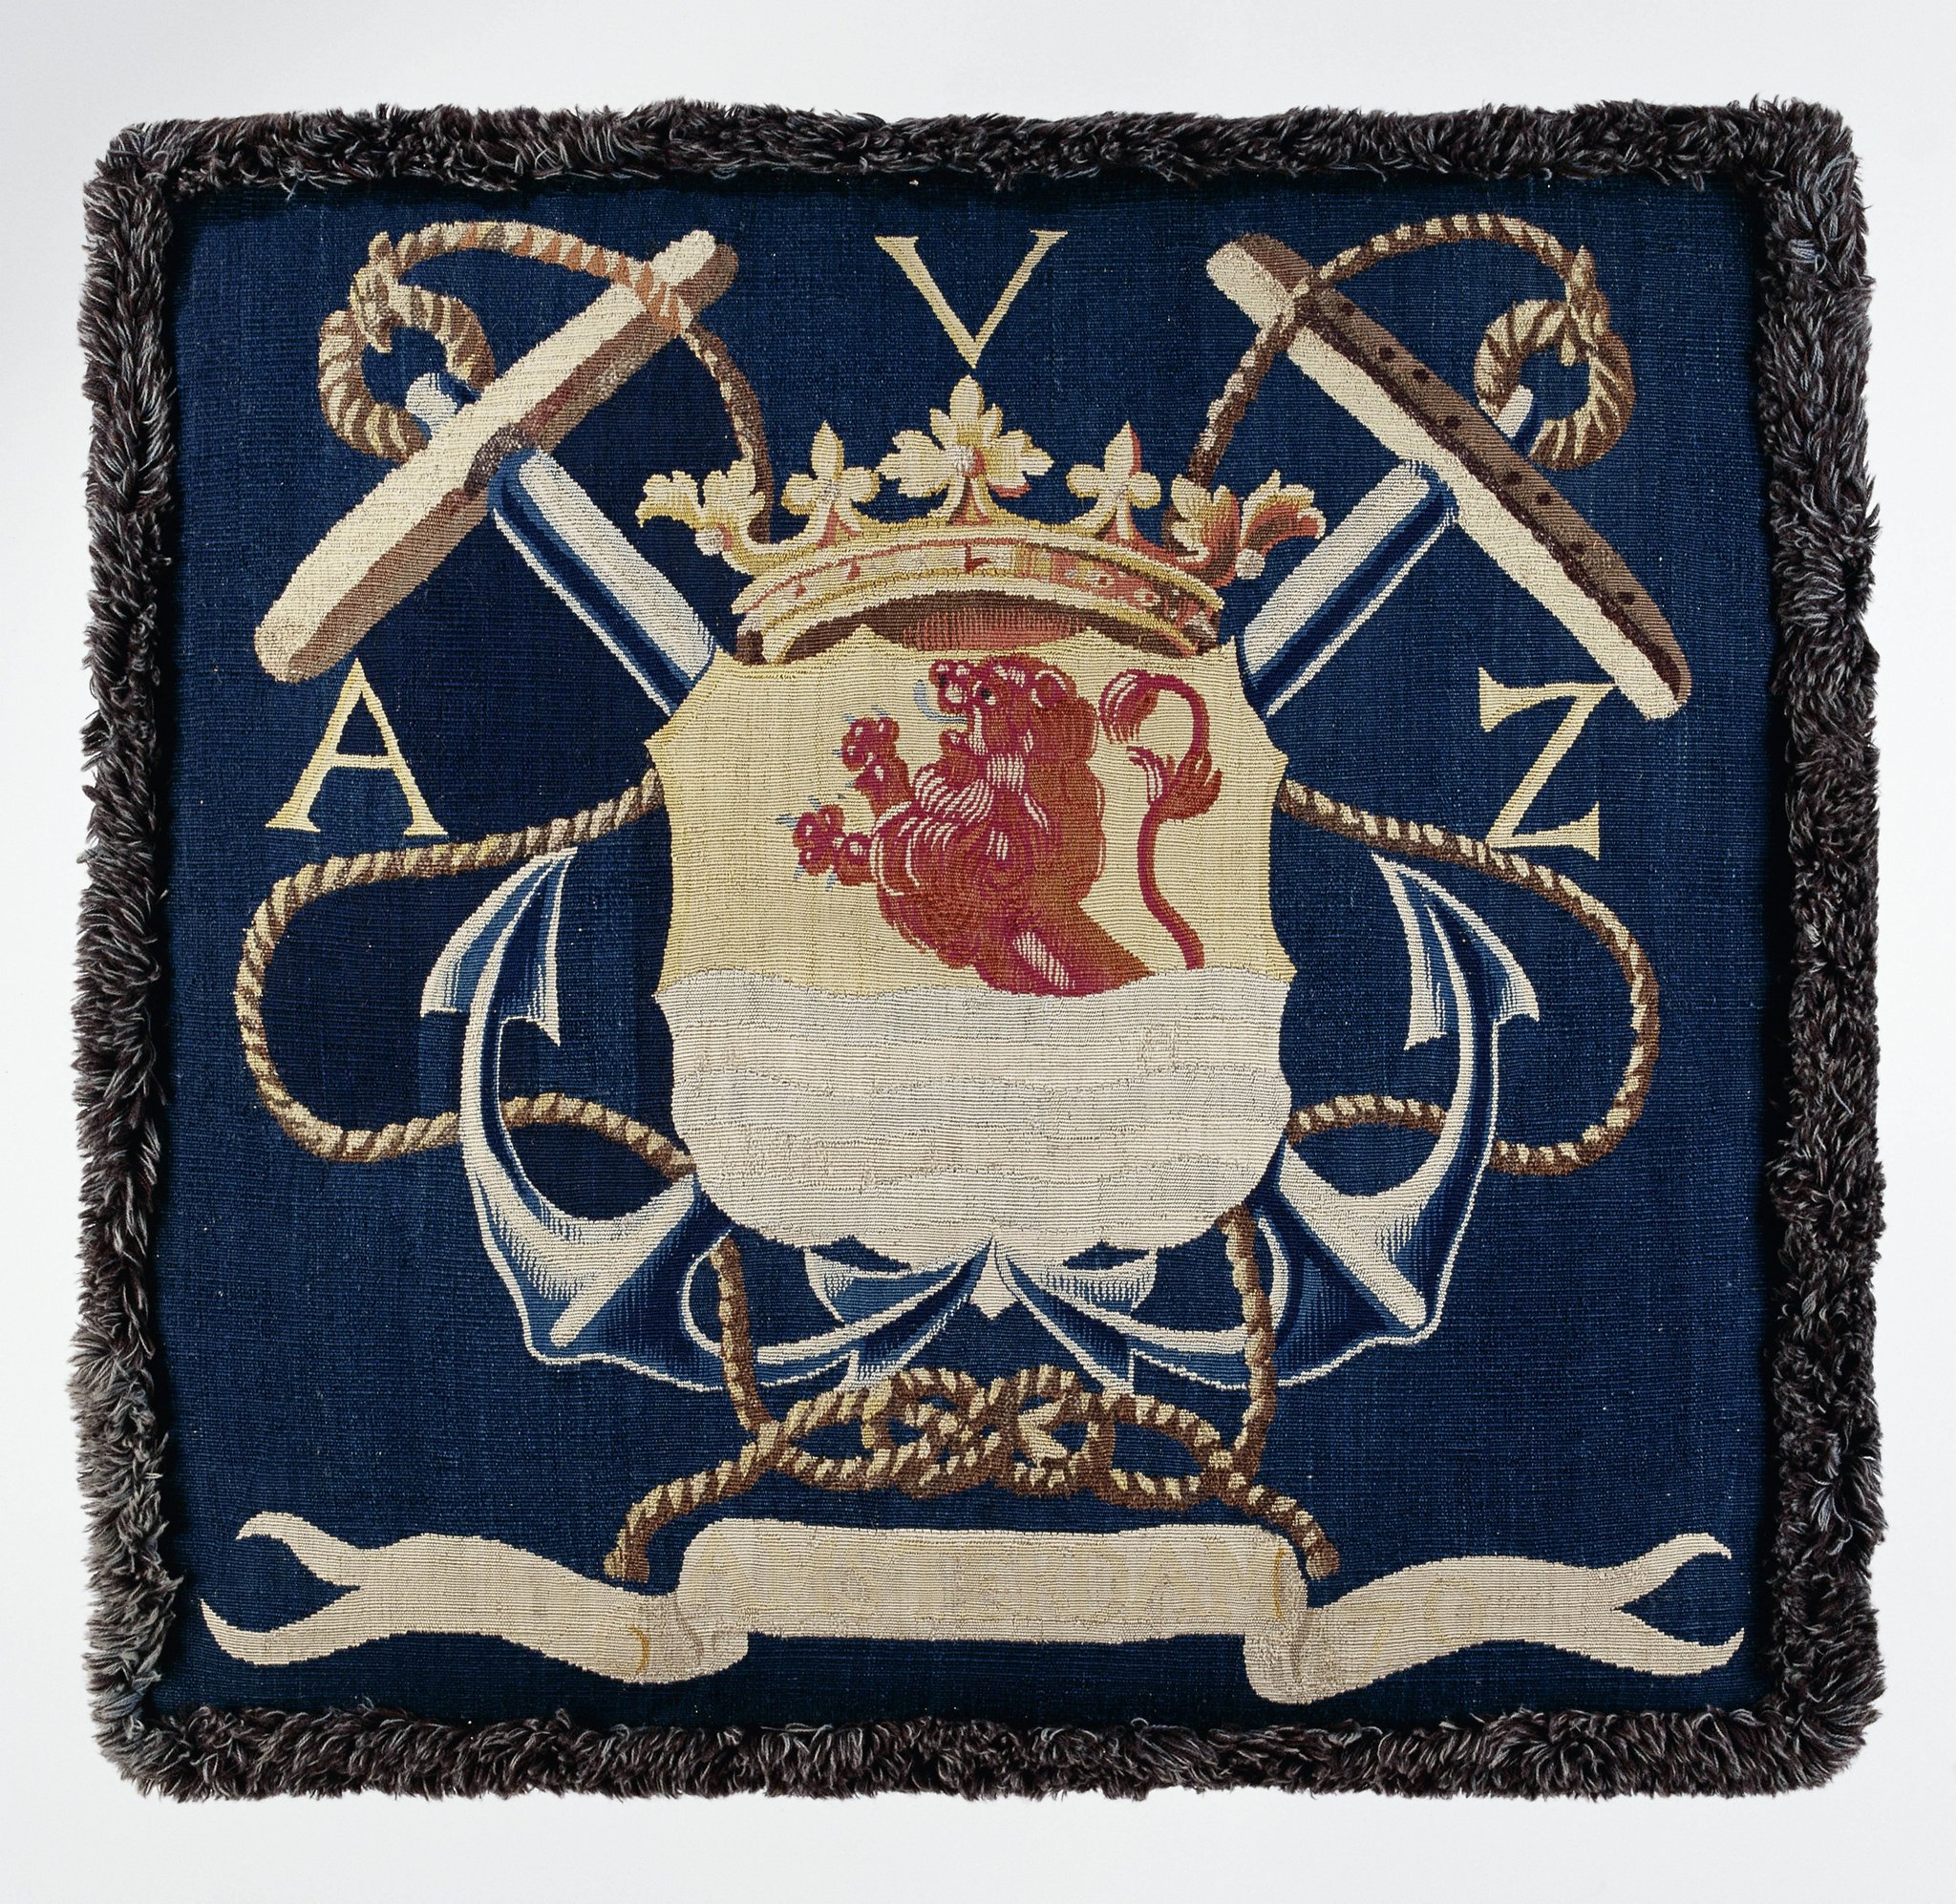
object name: pillow sham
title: Kussenovertrek met het wapen van de Admiraliteit van Zeeland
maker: Anonymous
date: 1670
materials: linen, silk, wool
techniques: tapestry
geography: northern netherlands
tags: middelburg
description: Kussenovertrek van tapisserieweefsel. Tegen een donkerblauwe achtergrond is het gekroonde wapen van Zeeland aangebracht, de leeuw in rood, het water in blauw. In de beide bovenhoeken een anker, voorts touwen. Boven de letters A.V.Z. en onder AMSTERDAM 1670.